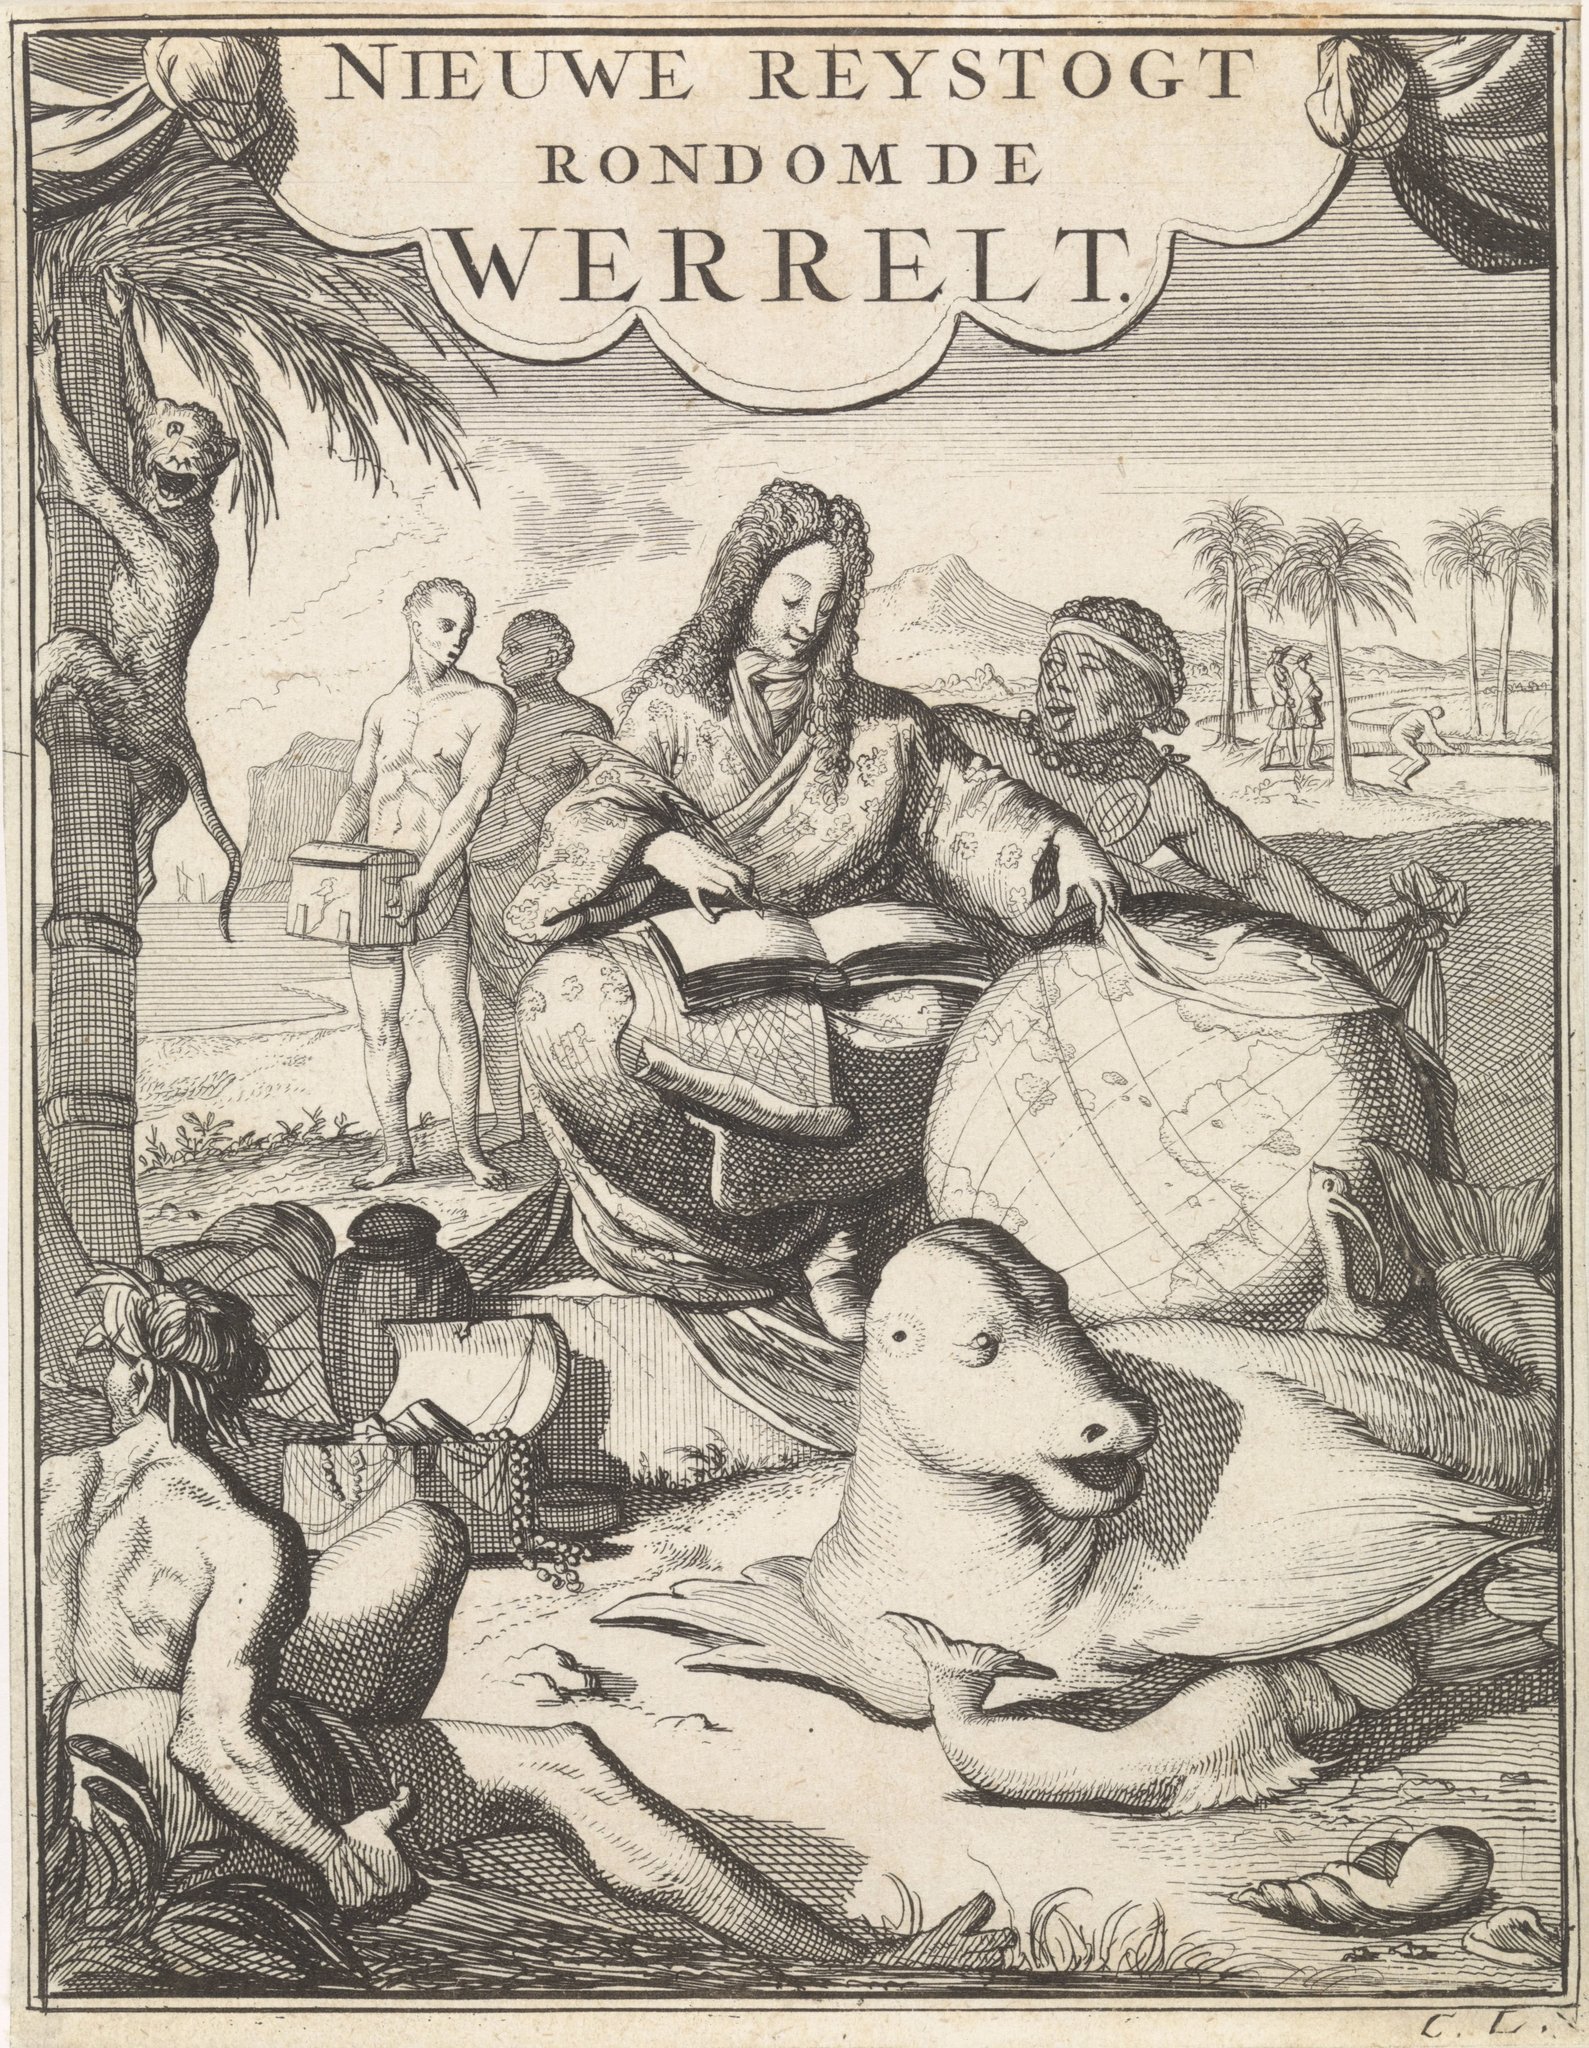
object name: print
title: Titelpagina voor: W. Dampier, Nieuwe reystogt rondom de werreld, 1698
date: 1698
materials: paper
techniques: etching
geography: amsterdam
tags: indigenous peoples of north america, landscapes in the non-temperate zone, exotic landscapes, exploration, expedition, voyage of discovery, native peoples of the americas, globe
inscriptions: collector's mark: Lugt 2228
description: William Dampier, zittend in een landschap, beschrijft zijn reis om de wereld. Hij schrijft met een ganzenveer in het boek dat op zijn schoot ligt. Samen met een Afrikaanse man of vrouw tilt hij een sluier van de globe die voor hen staat. Op de voorgrond bevinden zich een riviergod, een aap, een zeekoe en een vogel. Op de achtergrond twee mannen waarvan de linker een kist draagt.